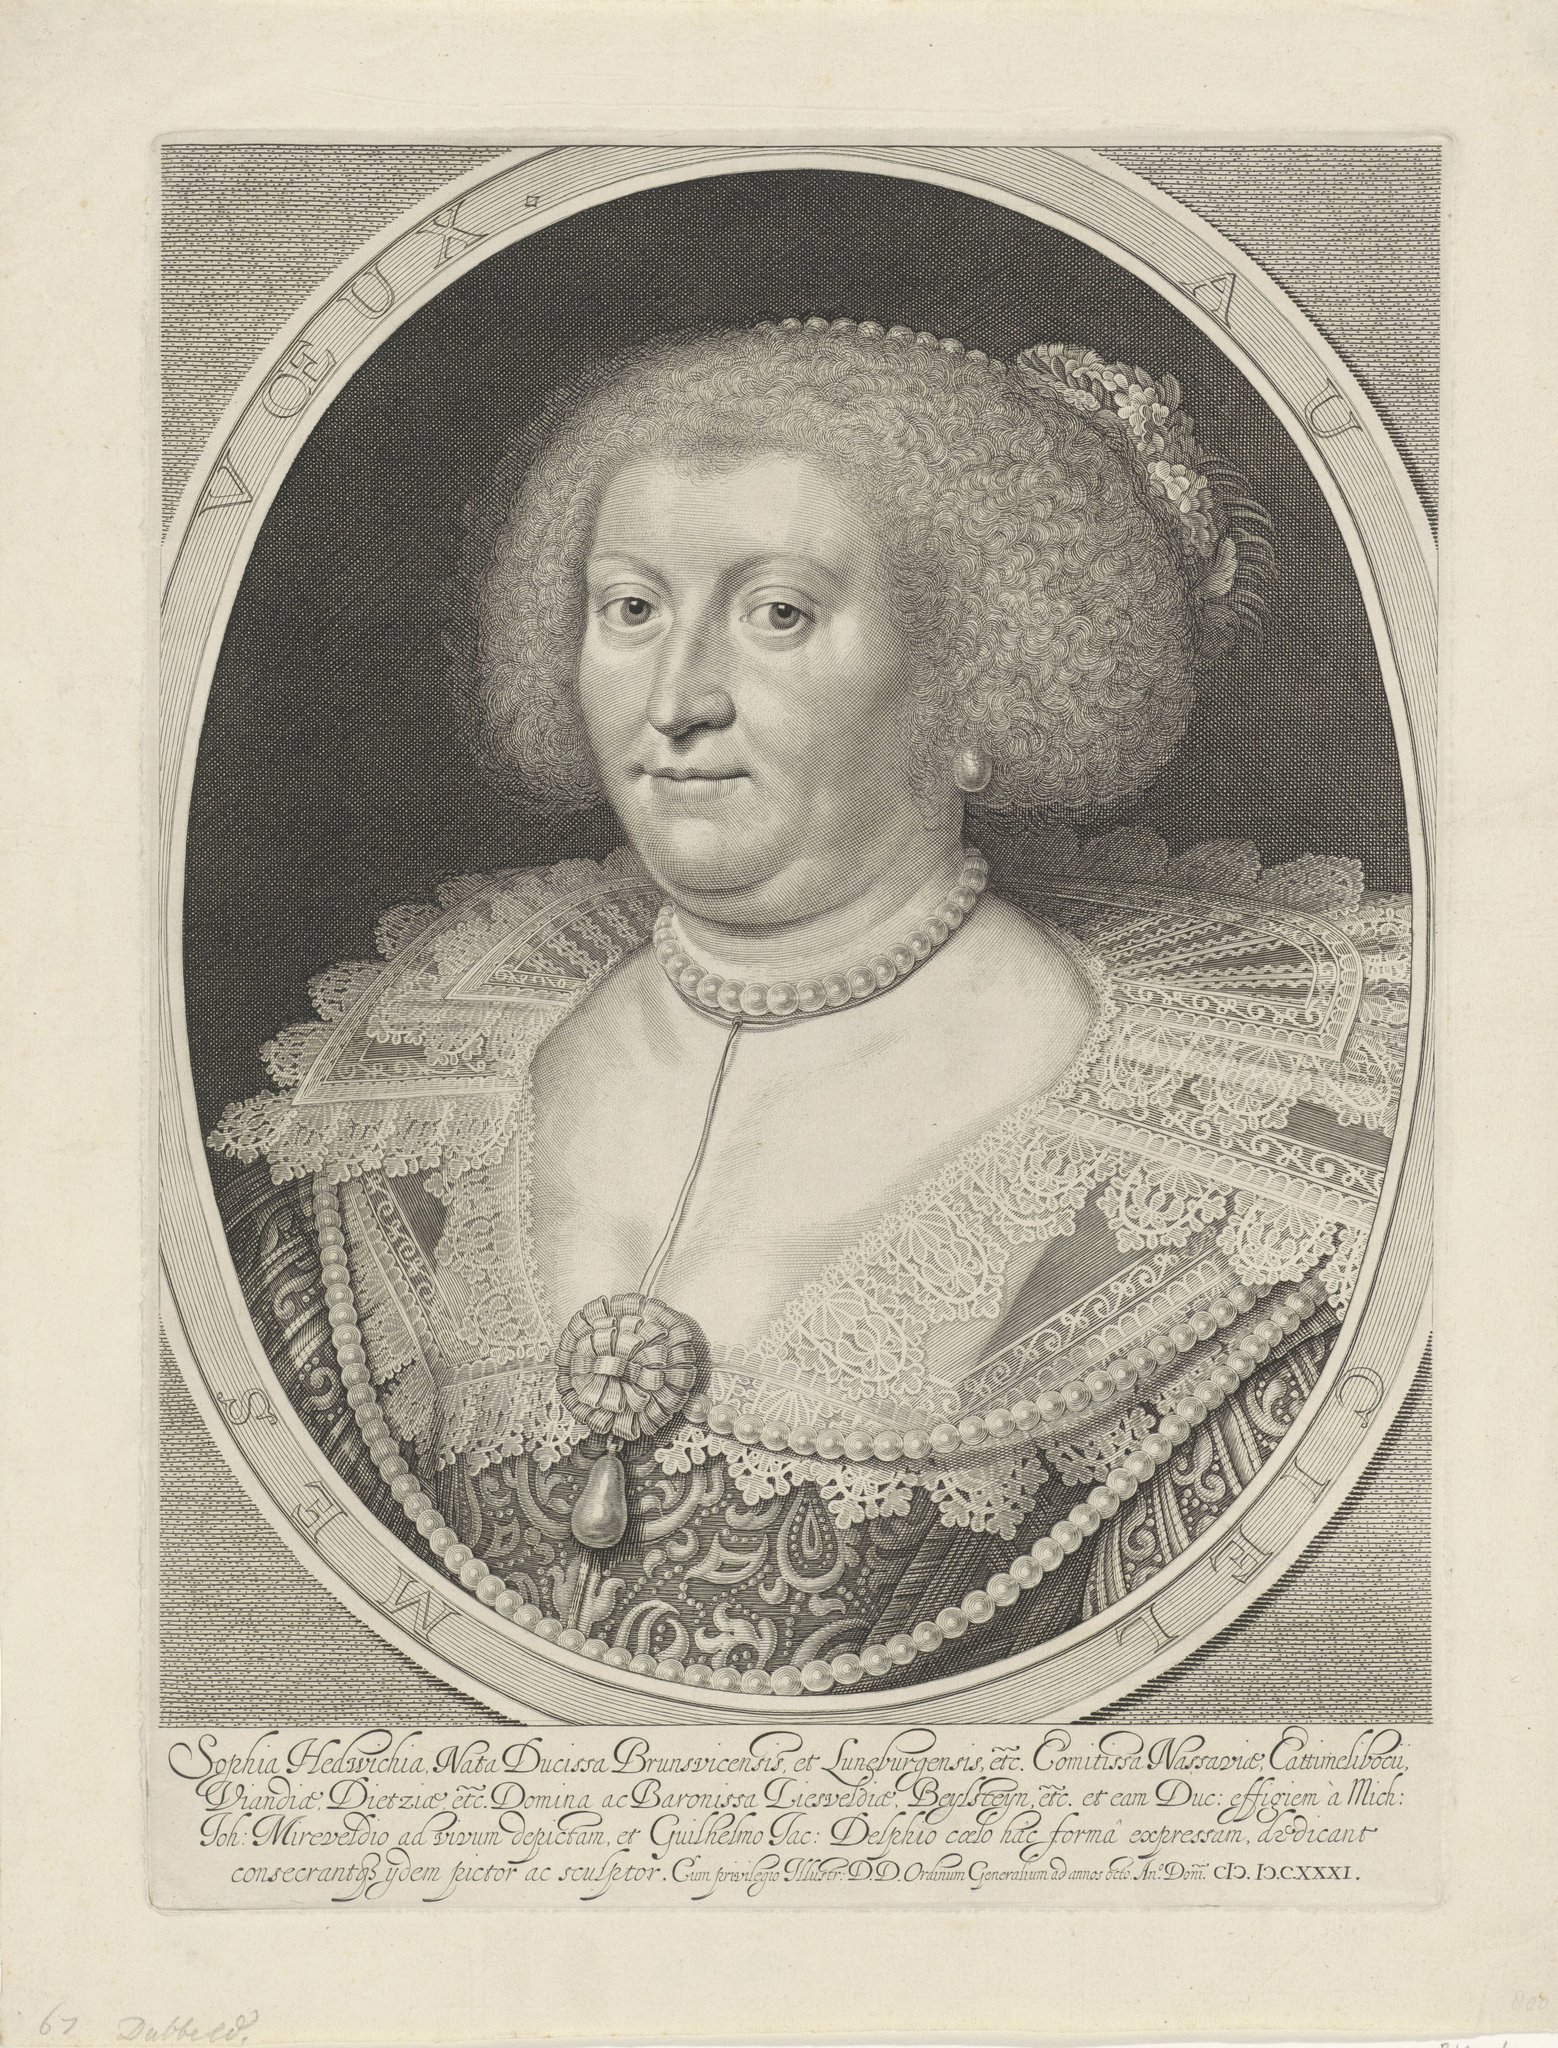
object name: print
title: Portret van Sophia Hedwig van Brunswijk-Wolfenbüttel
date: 1631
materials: paper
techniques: engraving, etching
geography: delft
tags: sophia hedwig van brunswijk-wolfenbüttel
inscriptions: collector's mark: Lugt 699, collector's mark: Lugt 2228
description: Portret van Sophia Hedwig van Brunswijk-Wolfenbüttel in een ovaal met randschrift. In de ondermarge vier regels Latijnse tekst.